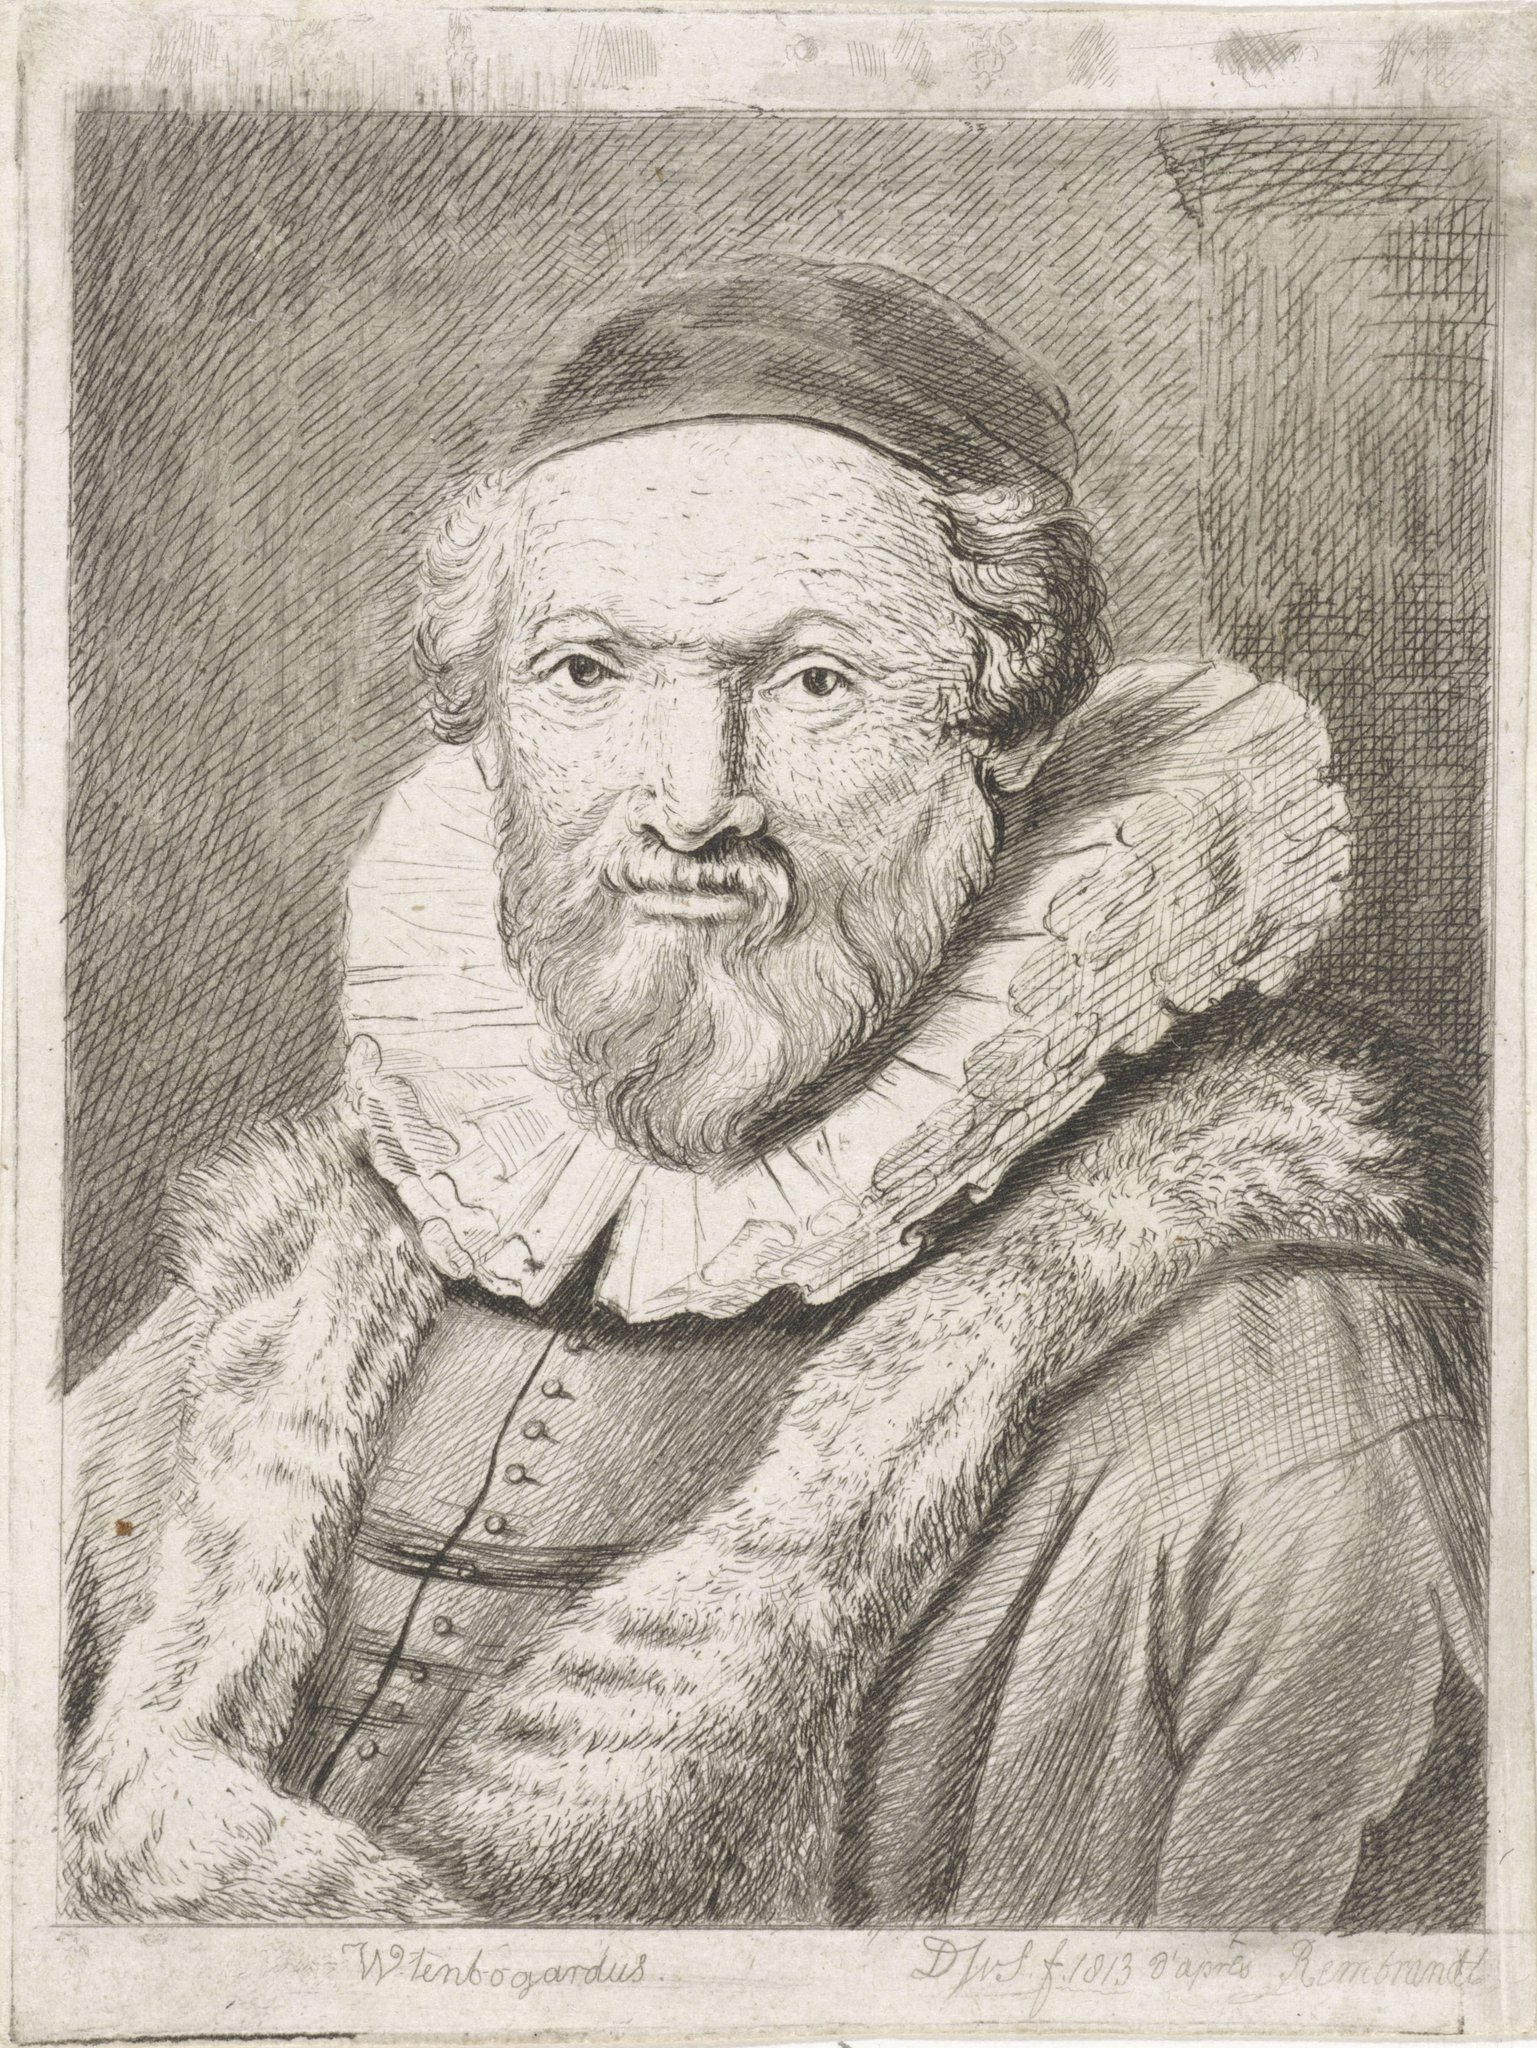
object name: print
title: Wtenbogardus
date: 1813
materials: paper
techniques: etching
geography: utrecht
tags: utrecht, the hague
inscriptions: date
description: Portret van Johannes Wtenbogaert, raadsman van Van Oldebarnevelt en hofpredikant van stadhouder prins Maurits.